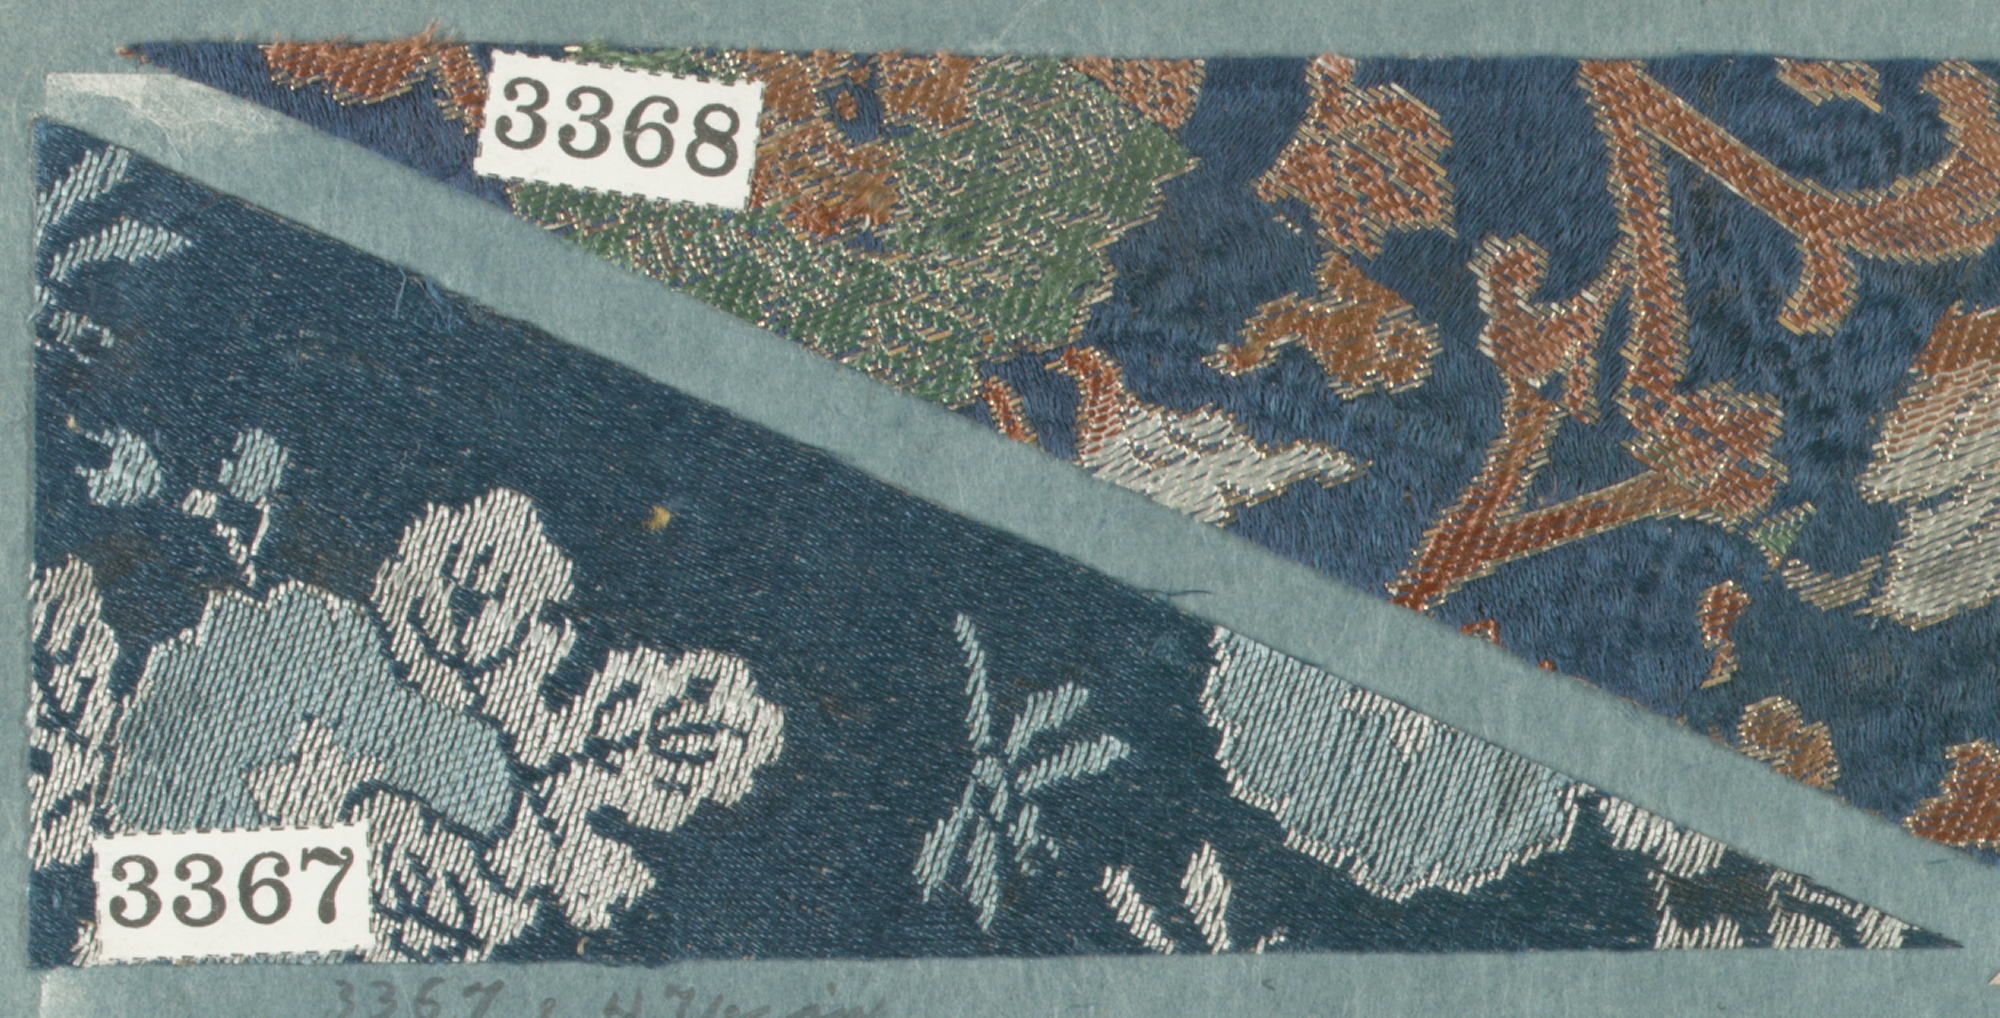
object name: textile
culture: japanese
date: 1801-1900